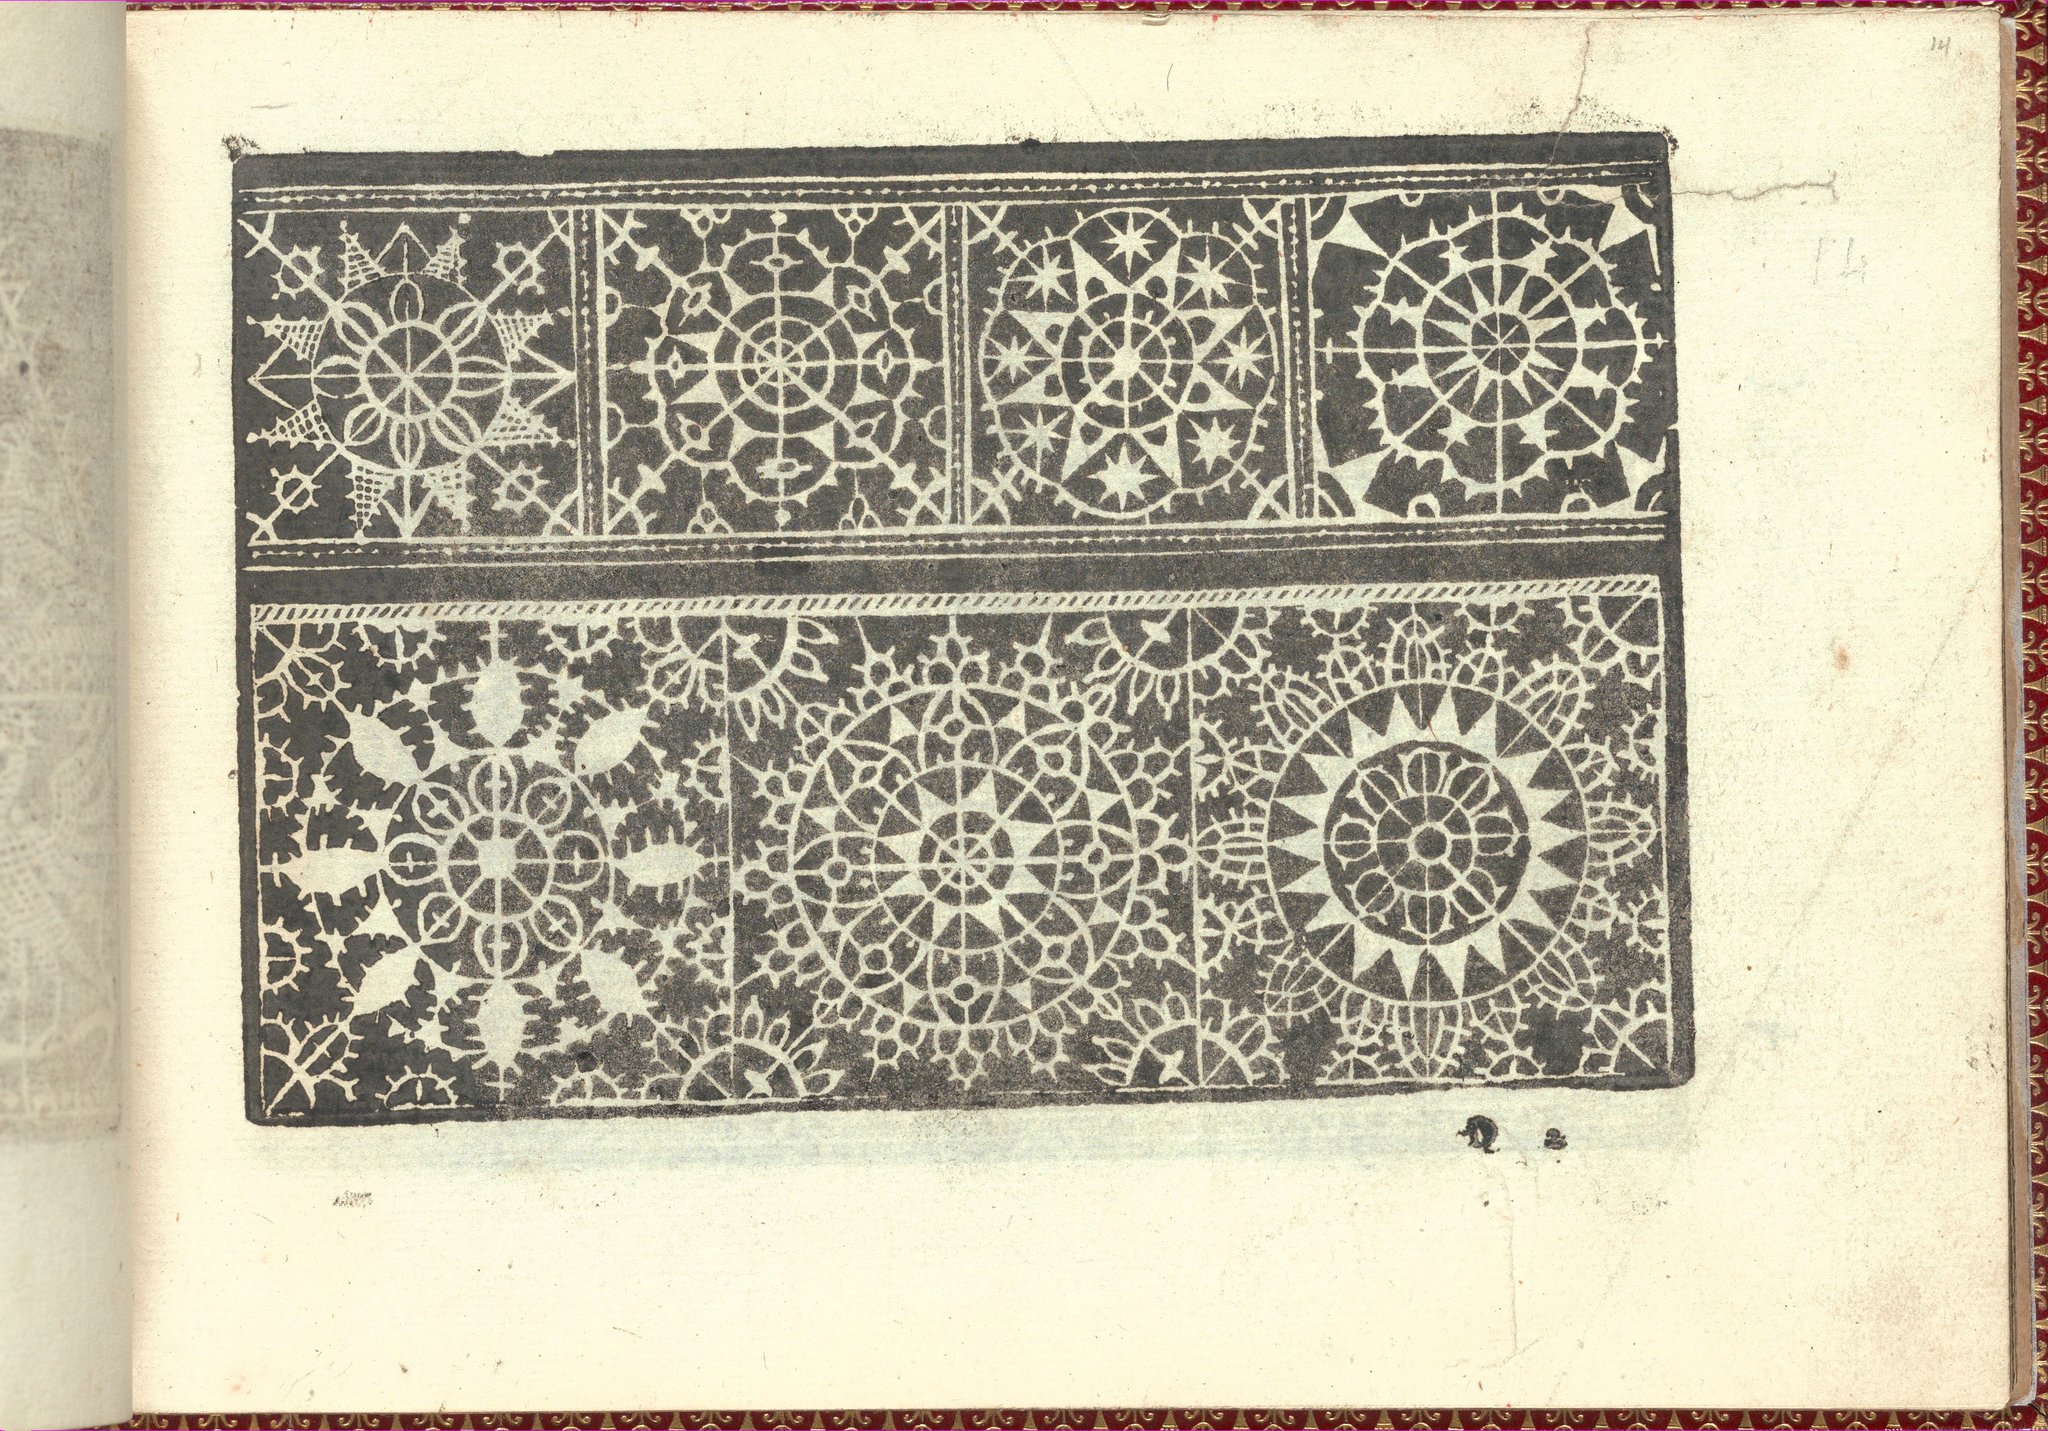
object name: book print ornament architecture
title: Corona delle Nobili et Virtuose Donne: Libro I-IV, page 14 (recto)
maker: cesare vecellio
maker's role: publisher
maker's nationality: italian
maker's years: 1521-1601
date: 1601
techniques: woodcut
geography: italy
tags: ornament